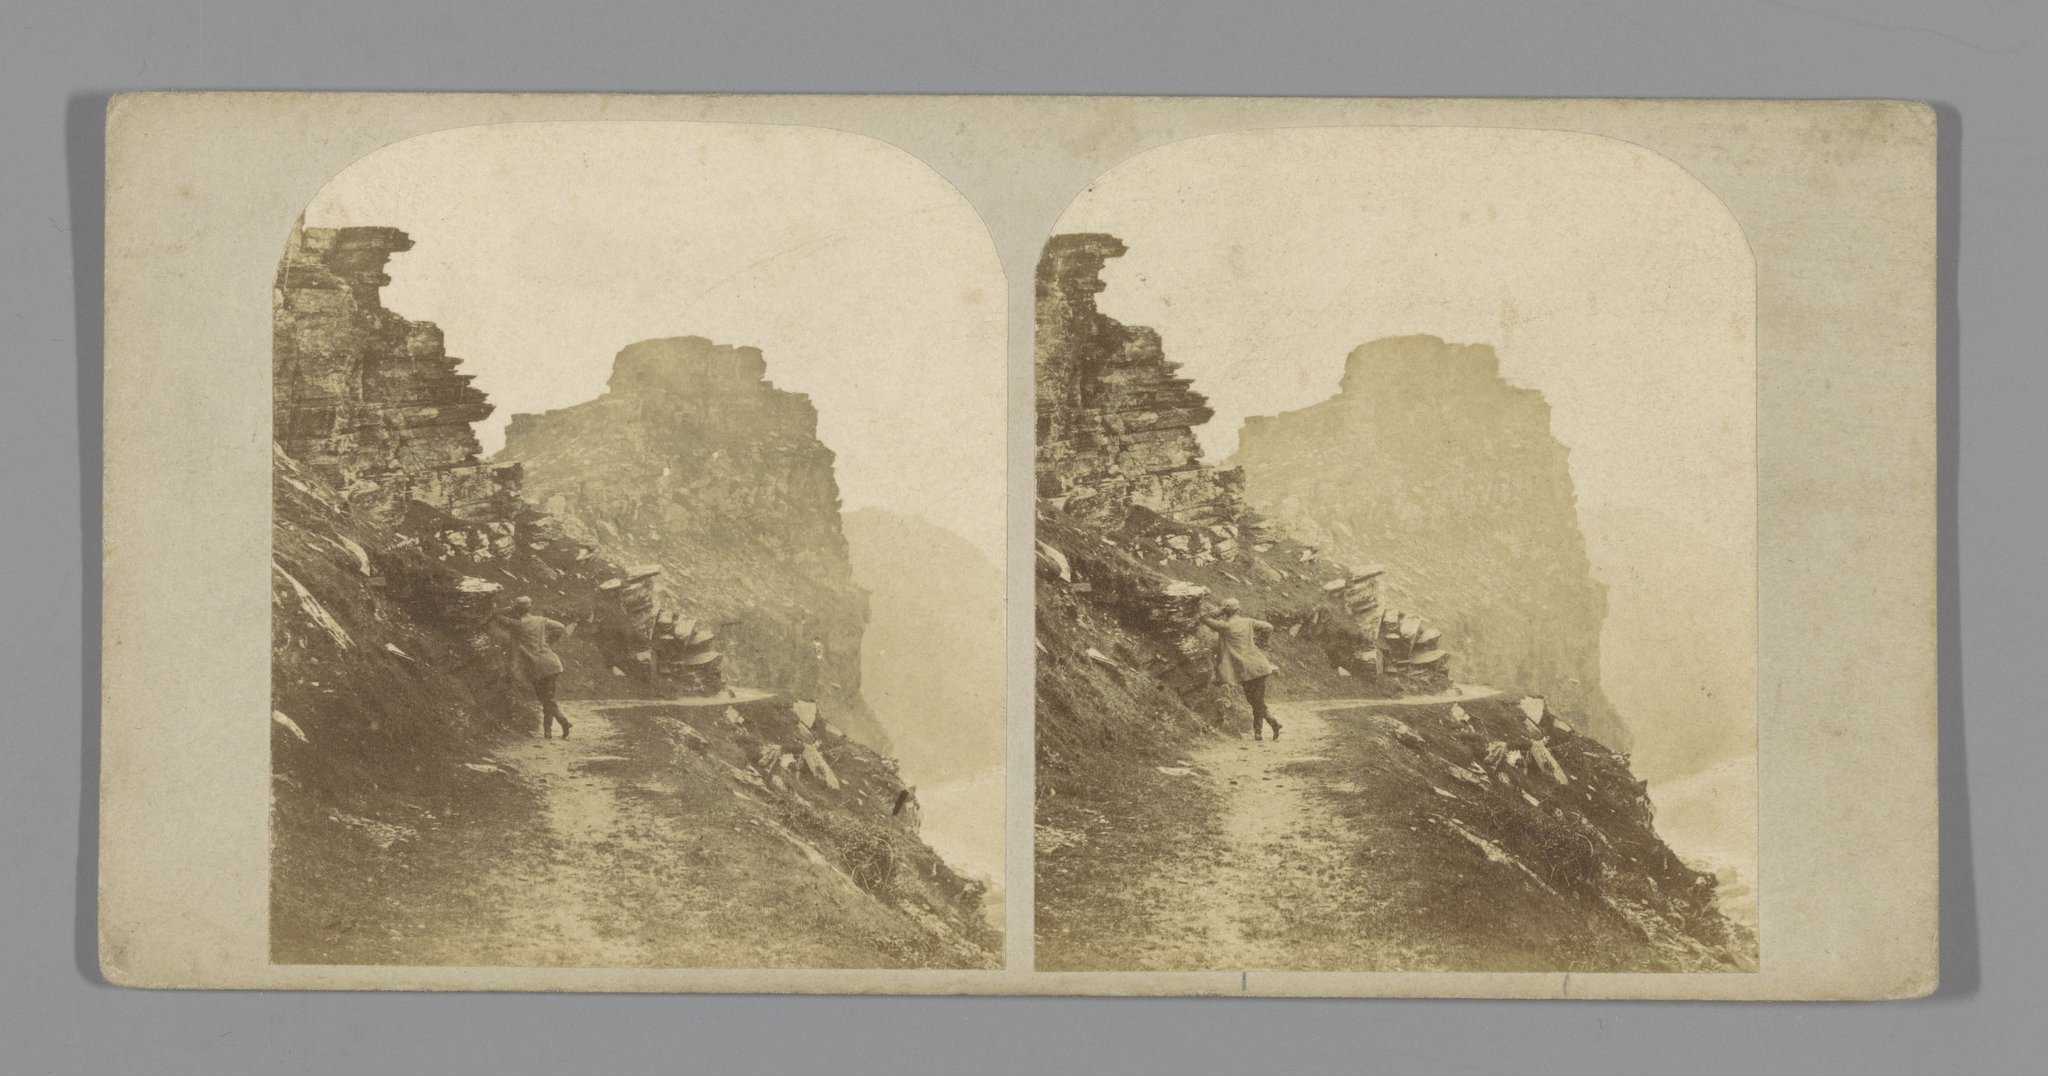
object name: stereograph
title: Pad langs de North Walk bij Lynton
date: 1850-1880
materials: cardboard, photographic support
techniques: albumen print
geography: lynton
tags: rock-formations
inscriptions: inscription: ‘Stereoscopic Treasures.’, number: ‘No. 19’